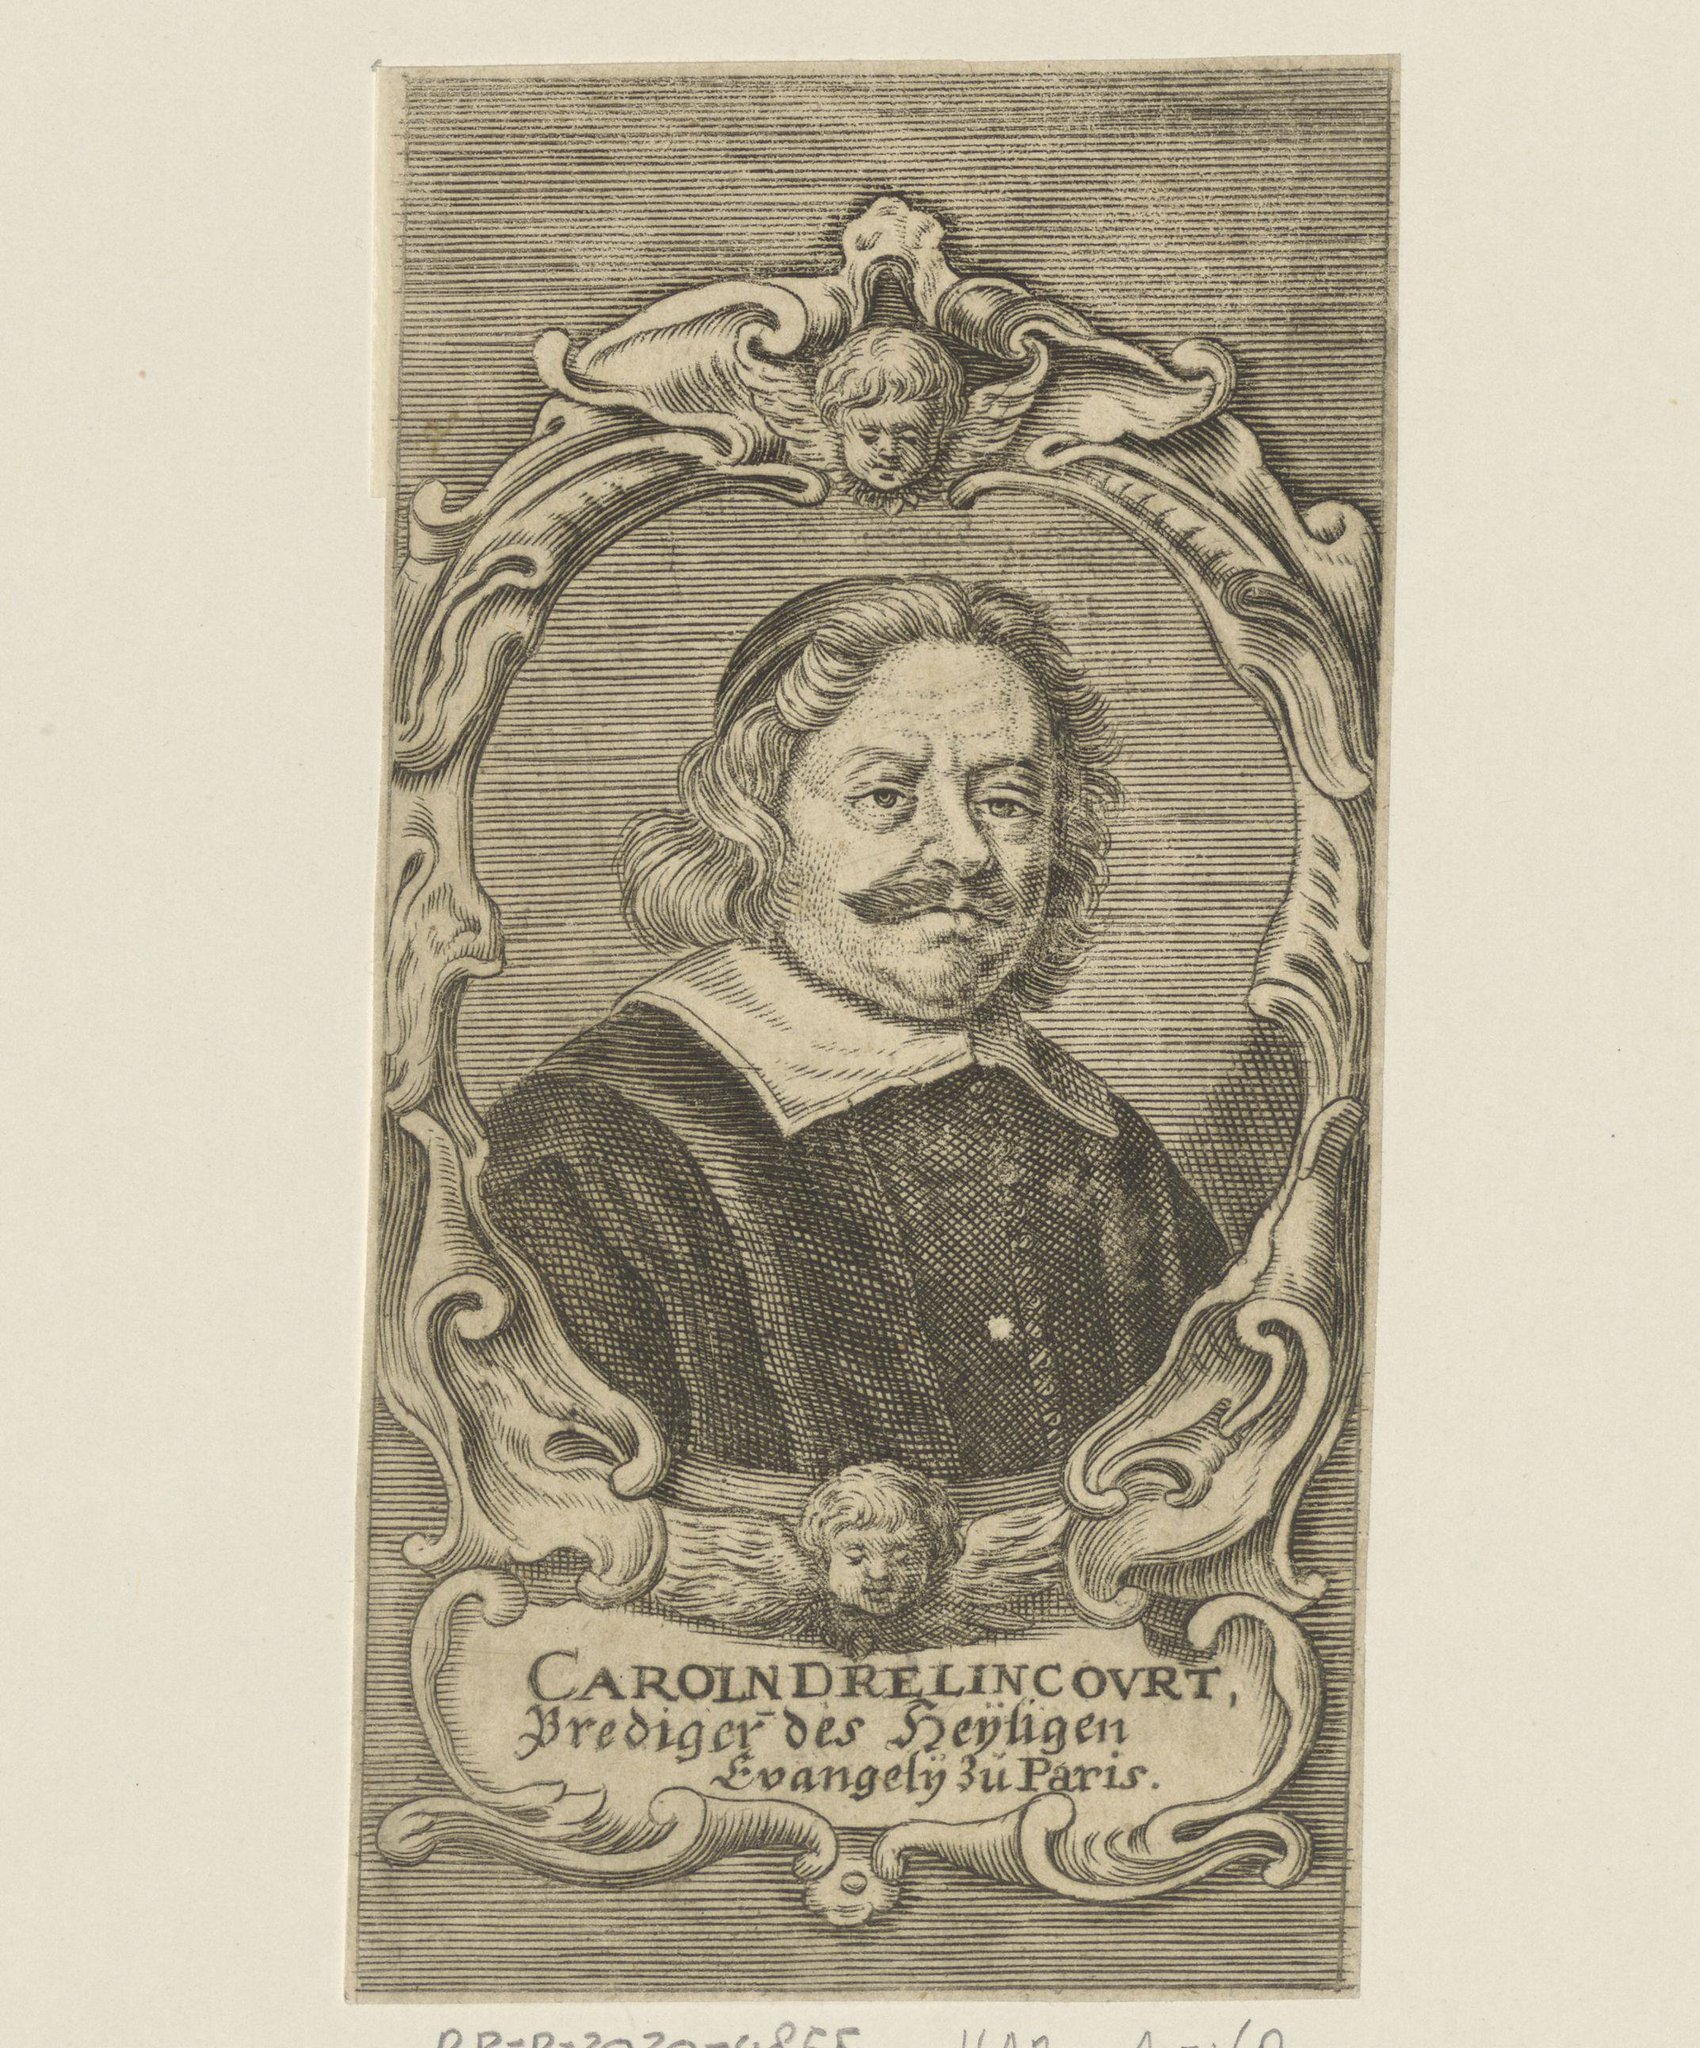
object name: print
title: Portret van Charles Drelincourt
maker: Anonymous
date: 1672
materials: paper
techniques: engraving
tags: theologian, historical persons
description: Prent mogelijk uit: Drelincourt, Charles. Liebreicher Besuchungen Oder Christlicher Trost. Hanau: Jacob Lasché, 1672.